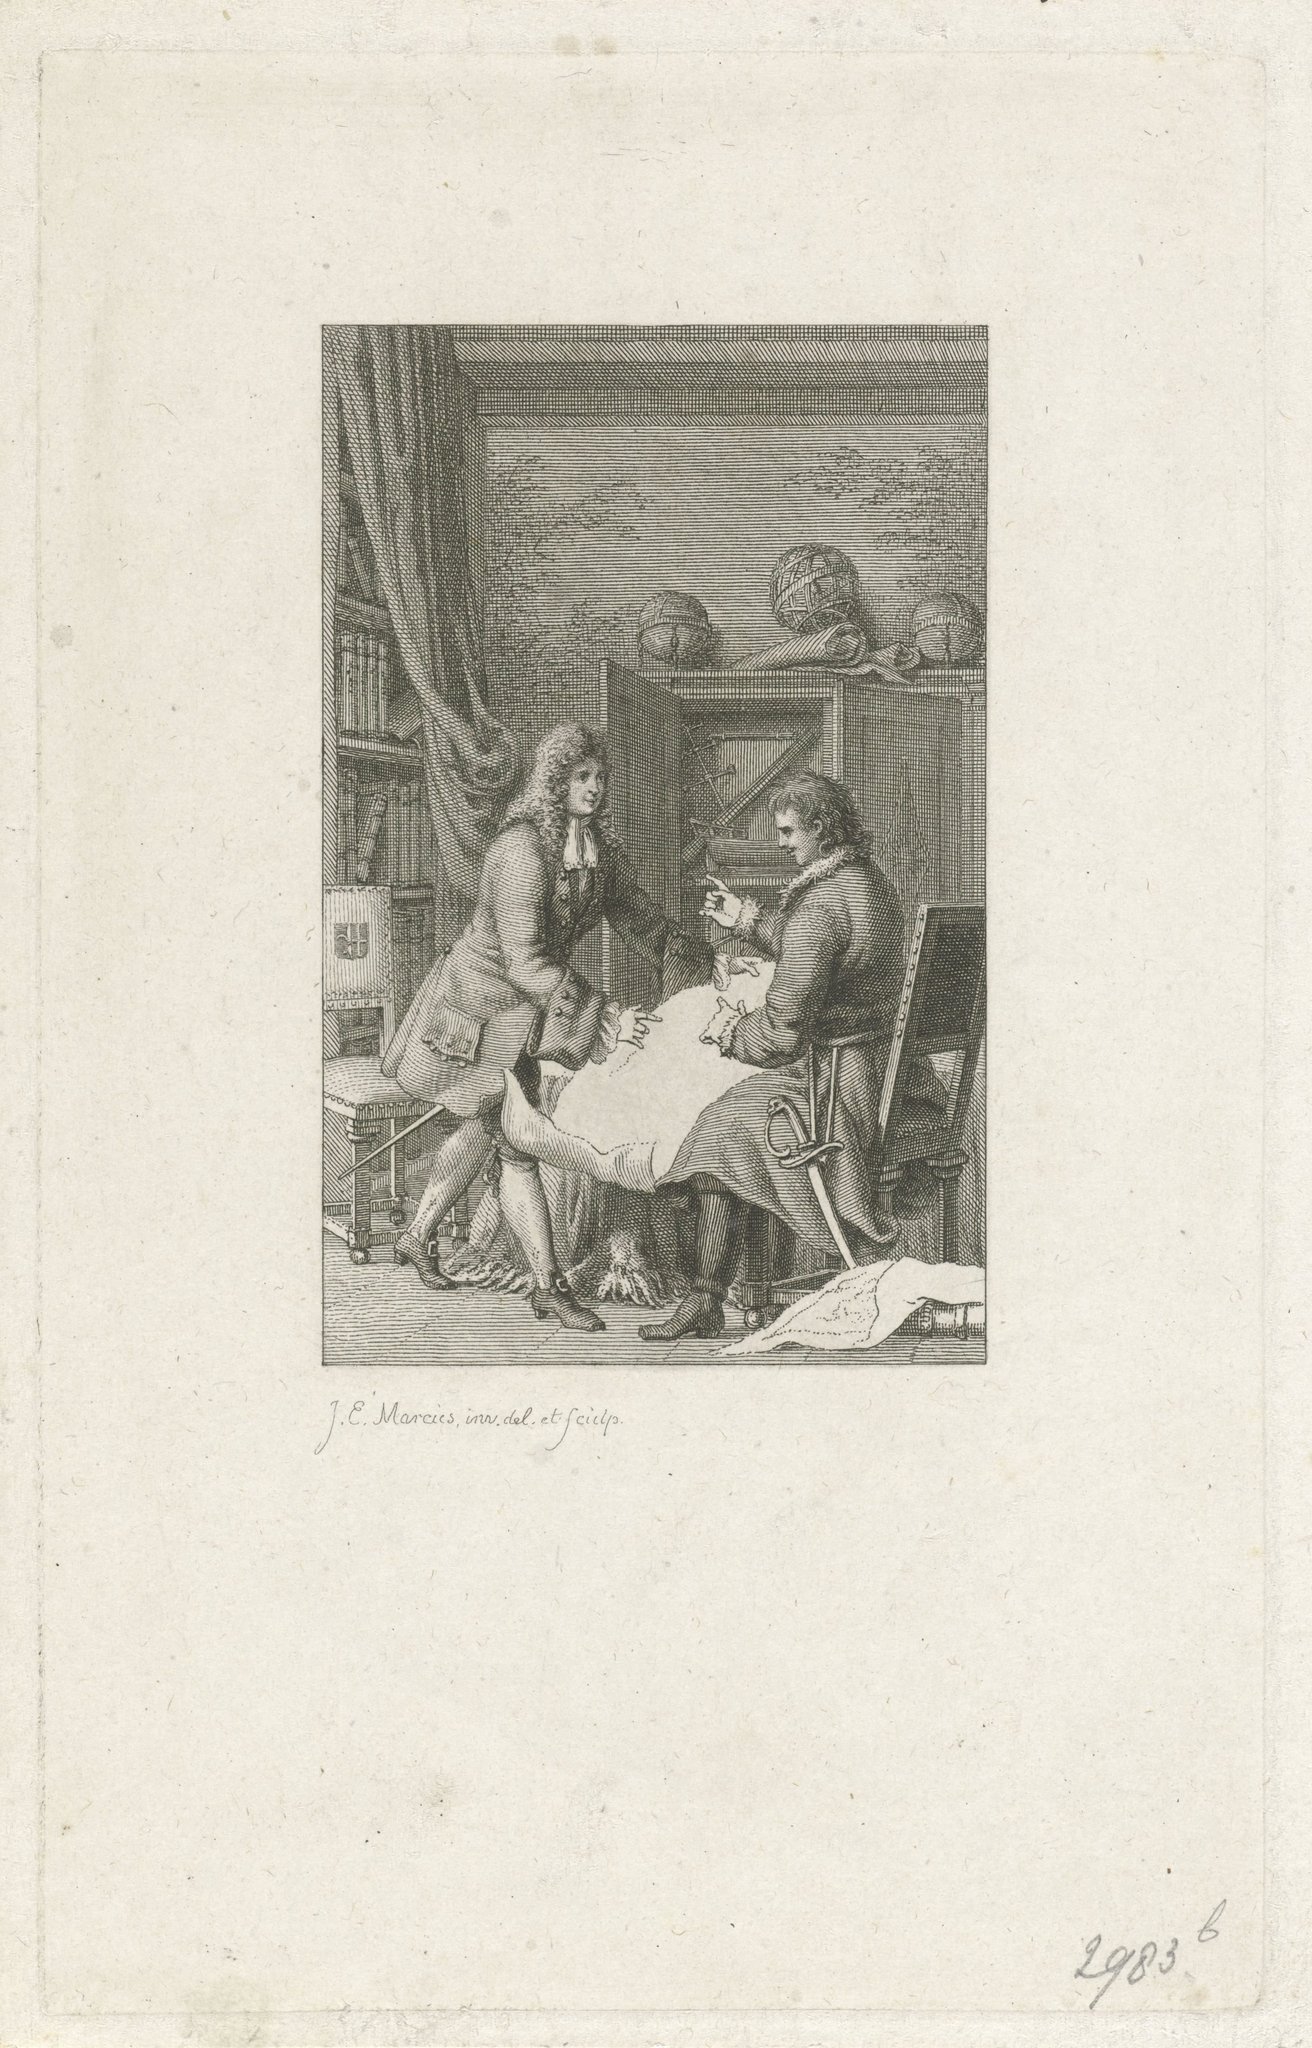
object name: print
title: Tsaar Peter de Grote en burgemeester Nicolaes Witsen bestuderen een kaart, 1697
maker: jacob ernst marcus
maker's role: draughtsman, print maker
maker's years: 1774-1826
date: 1814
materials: paper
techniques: etching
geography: amsterdam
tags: print maker, mayor, nicolaes cornelisz. witsen, peter i de grote (tsaar van rusland), maps, atlases, study; 'studiolo'; library, amsterdam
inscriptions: collector's mark: Lugt 2228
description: Tsaar Peter de Grote en burgemeester Nicolaes Witsen in een studeervertrek bestuderen samen een kaart, 1697. In een interieur kijken twee mannen op een nog niet ingevulde kaart. Op de achtergrond een geopende kast met daarop wereldbollen, een armillarium en opgerolde kaarten. Links een boekenkast.